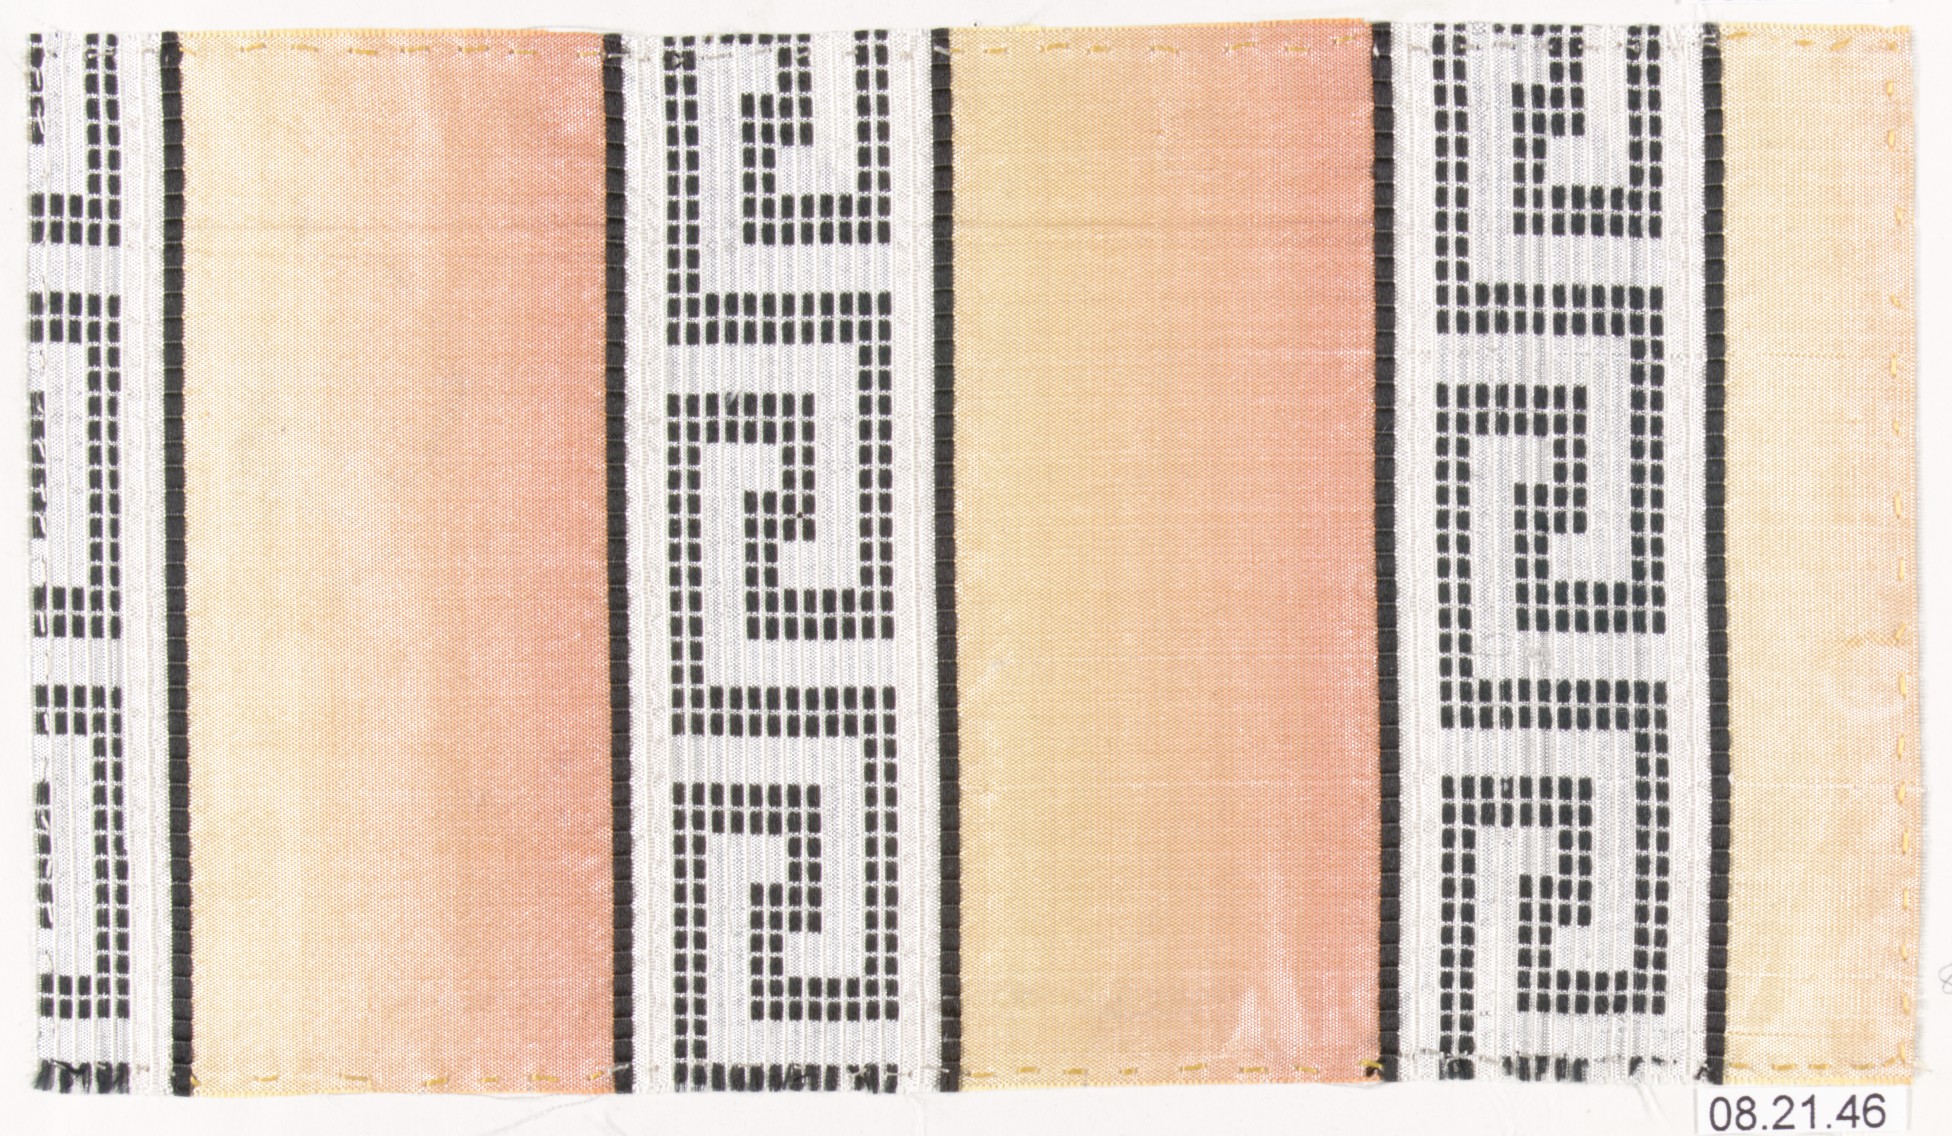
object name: textile sample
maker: Anonymous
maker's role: designer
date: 1900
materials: silk